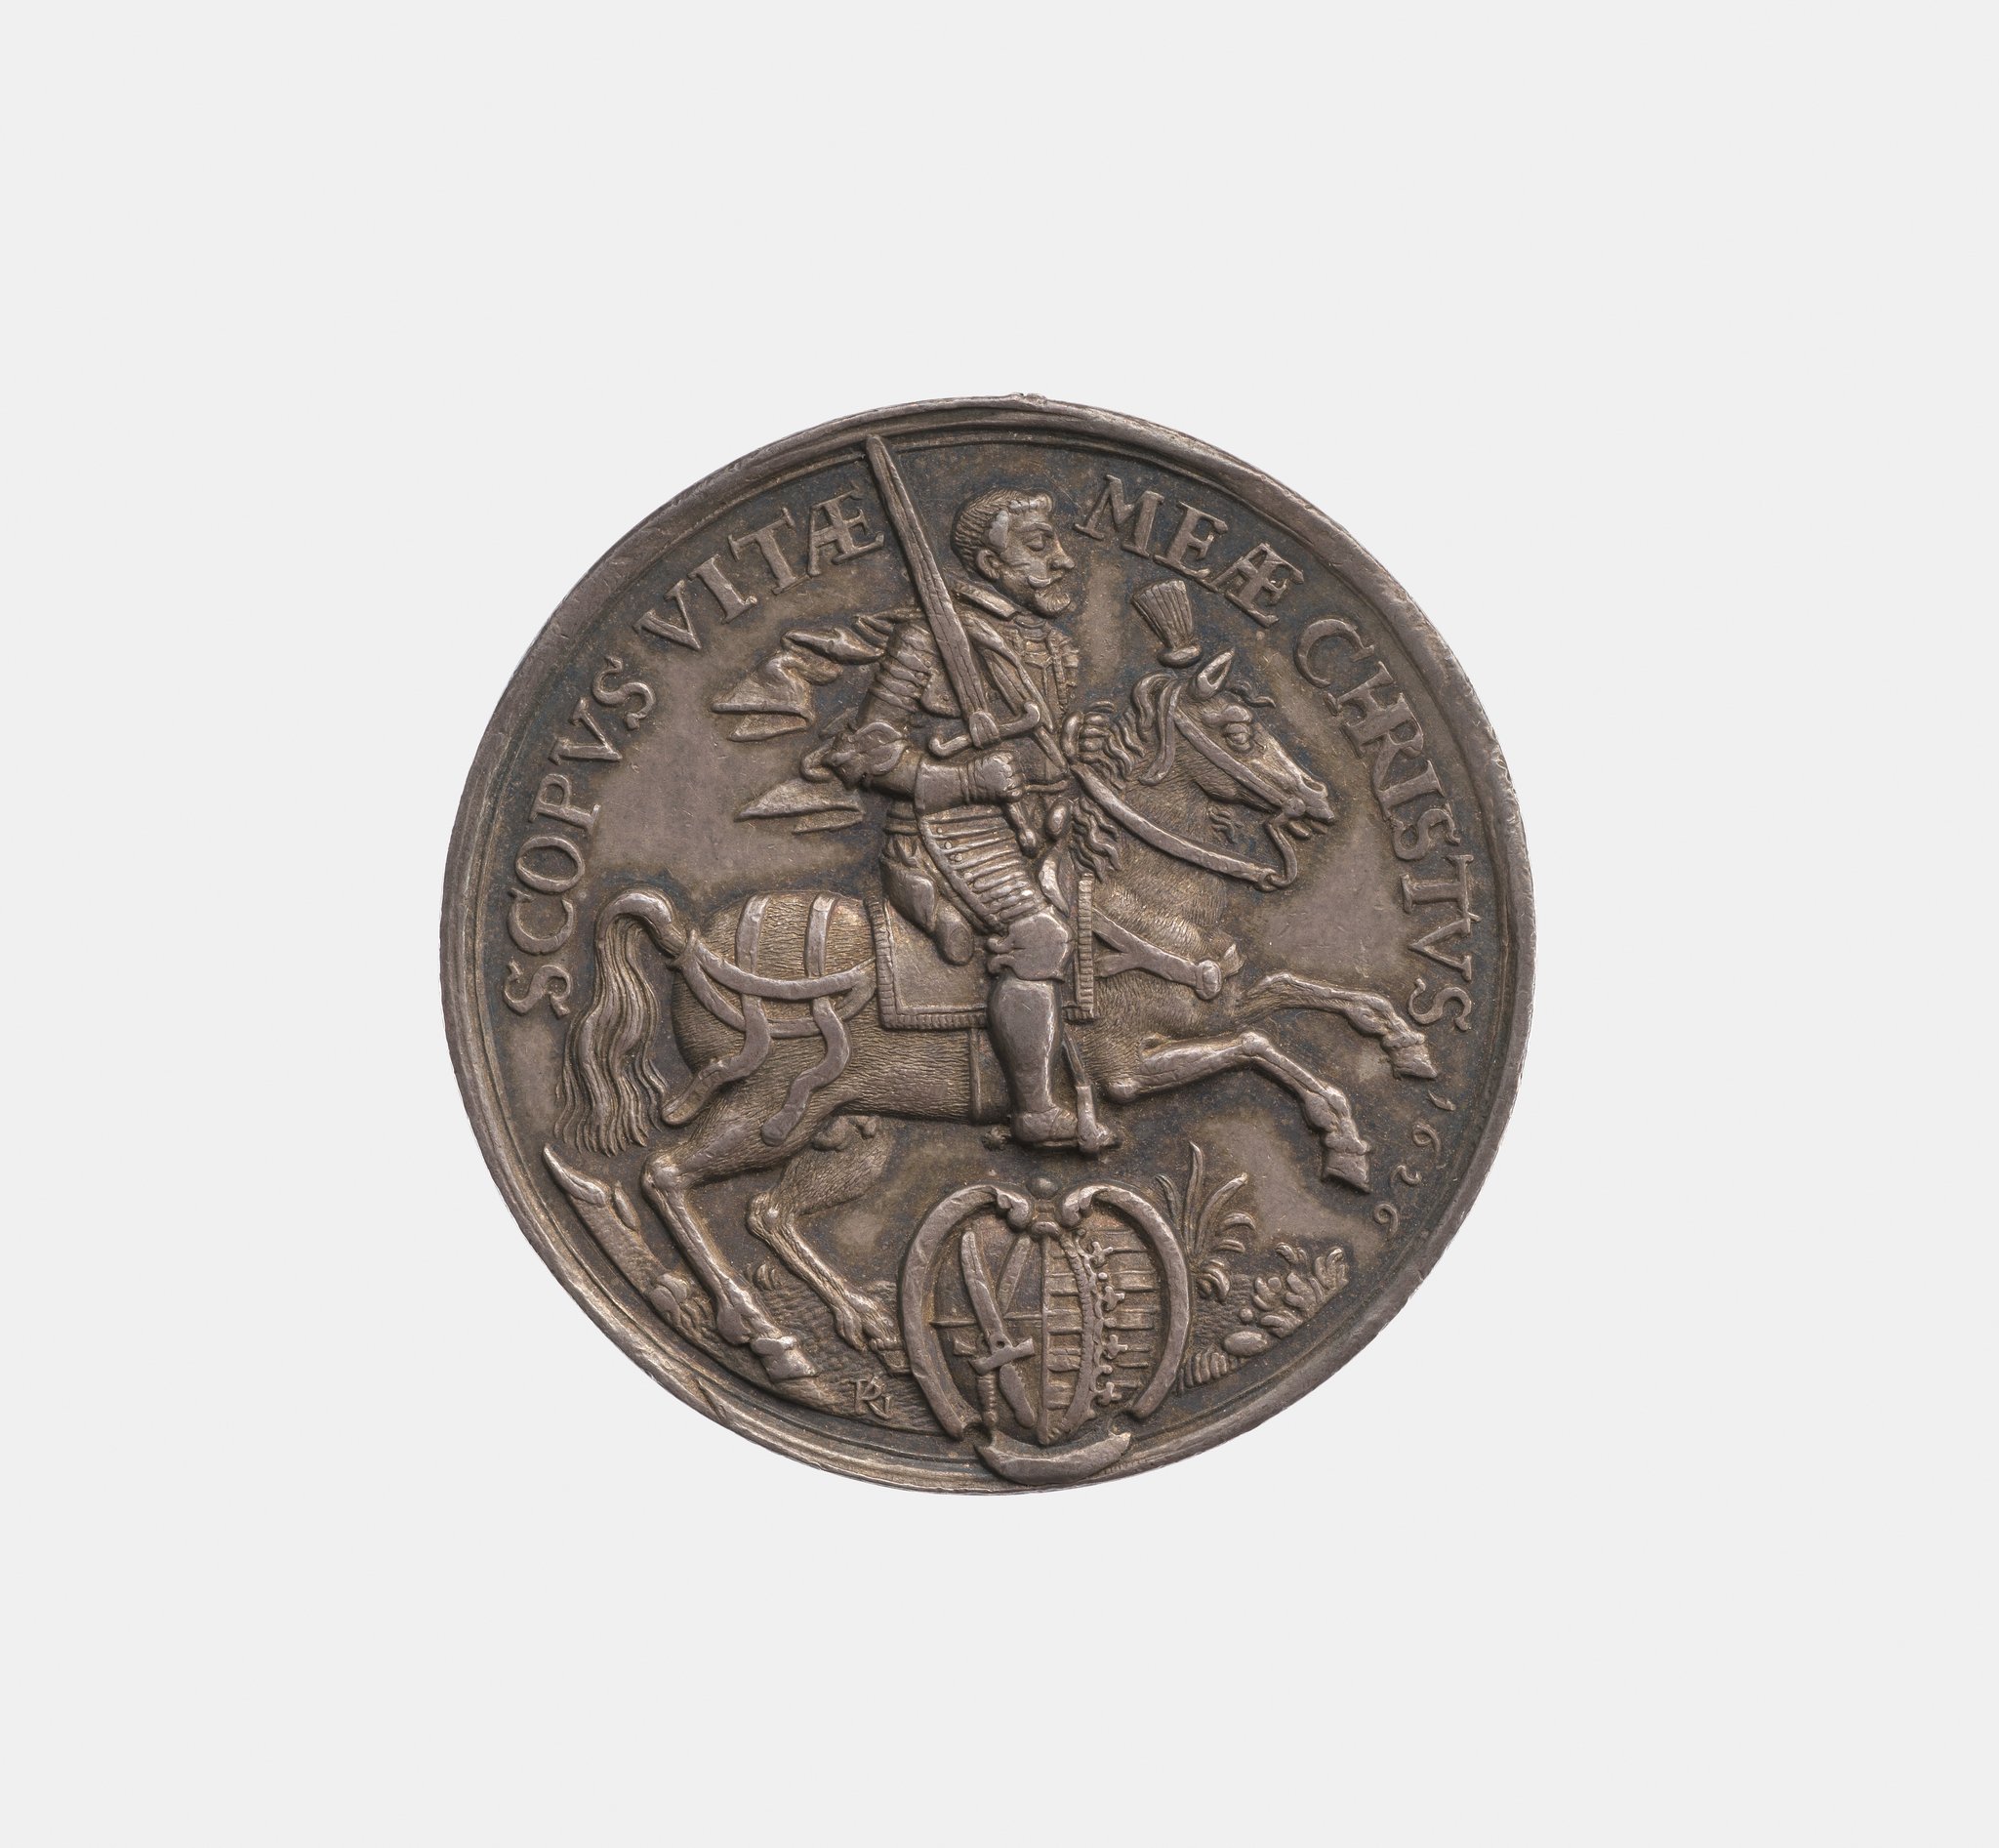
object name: medal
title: Johann Georg I, Elector of Saxony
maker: ruprecht niclas kitzbatz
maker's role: artist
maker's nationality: german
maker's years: 1615-1633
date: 1626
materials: silver